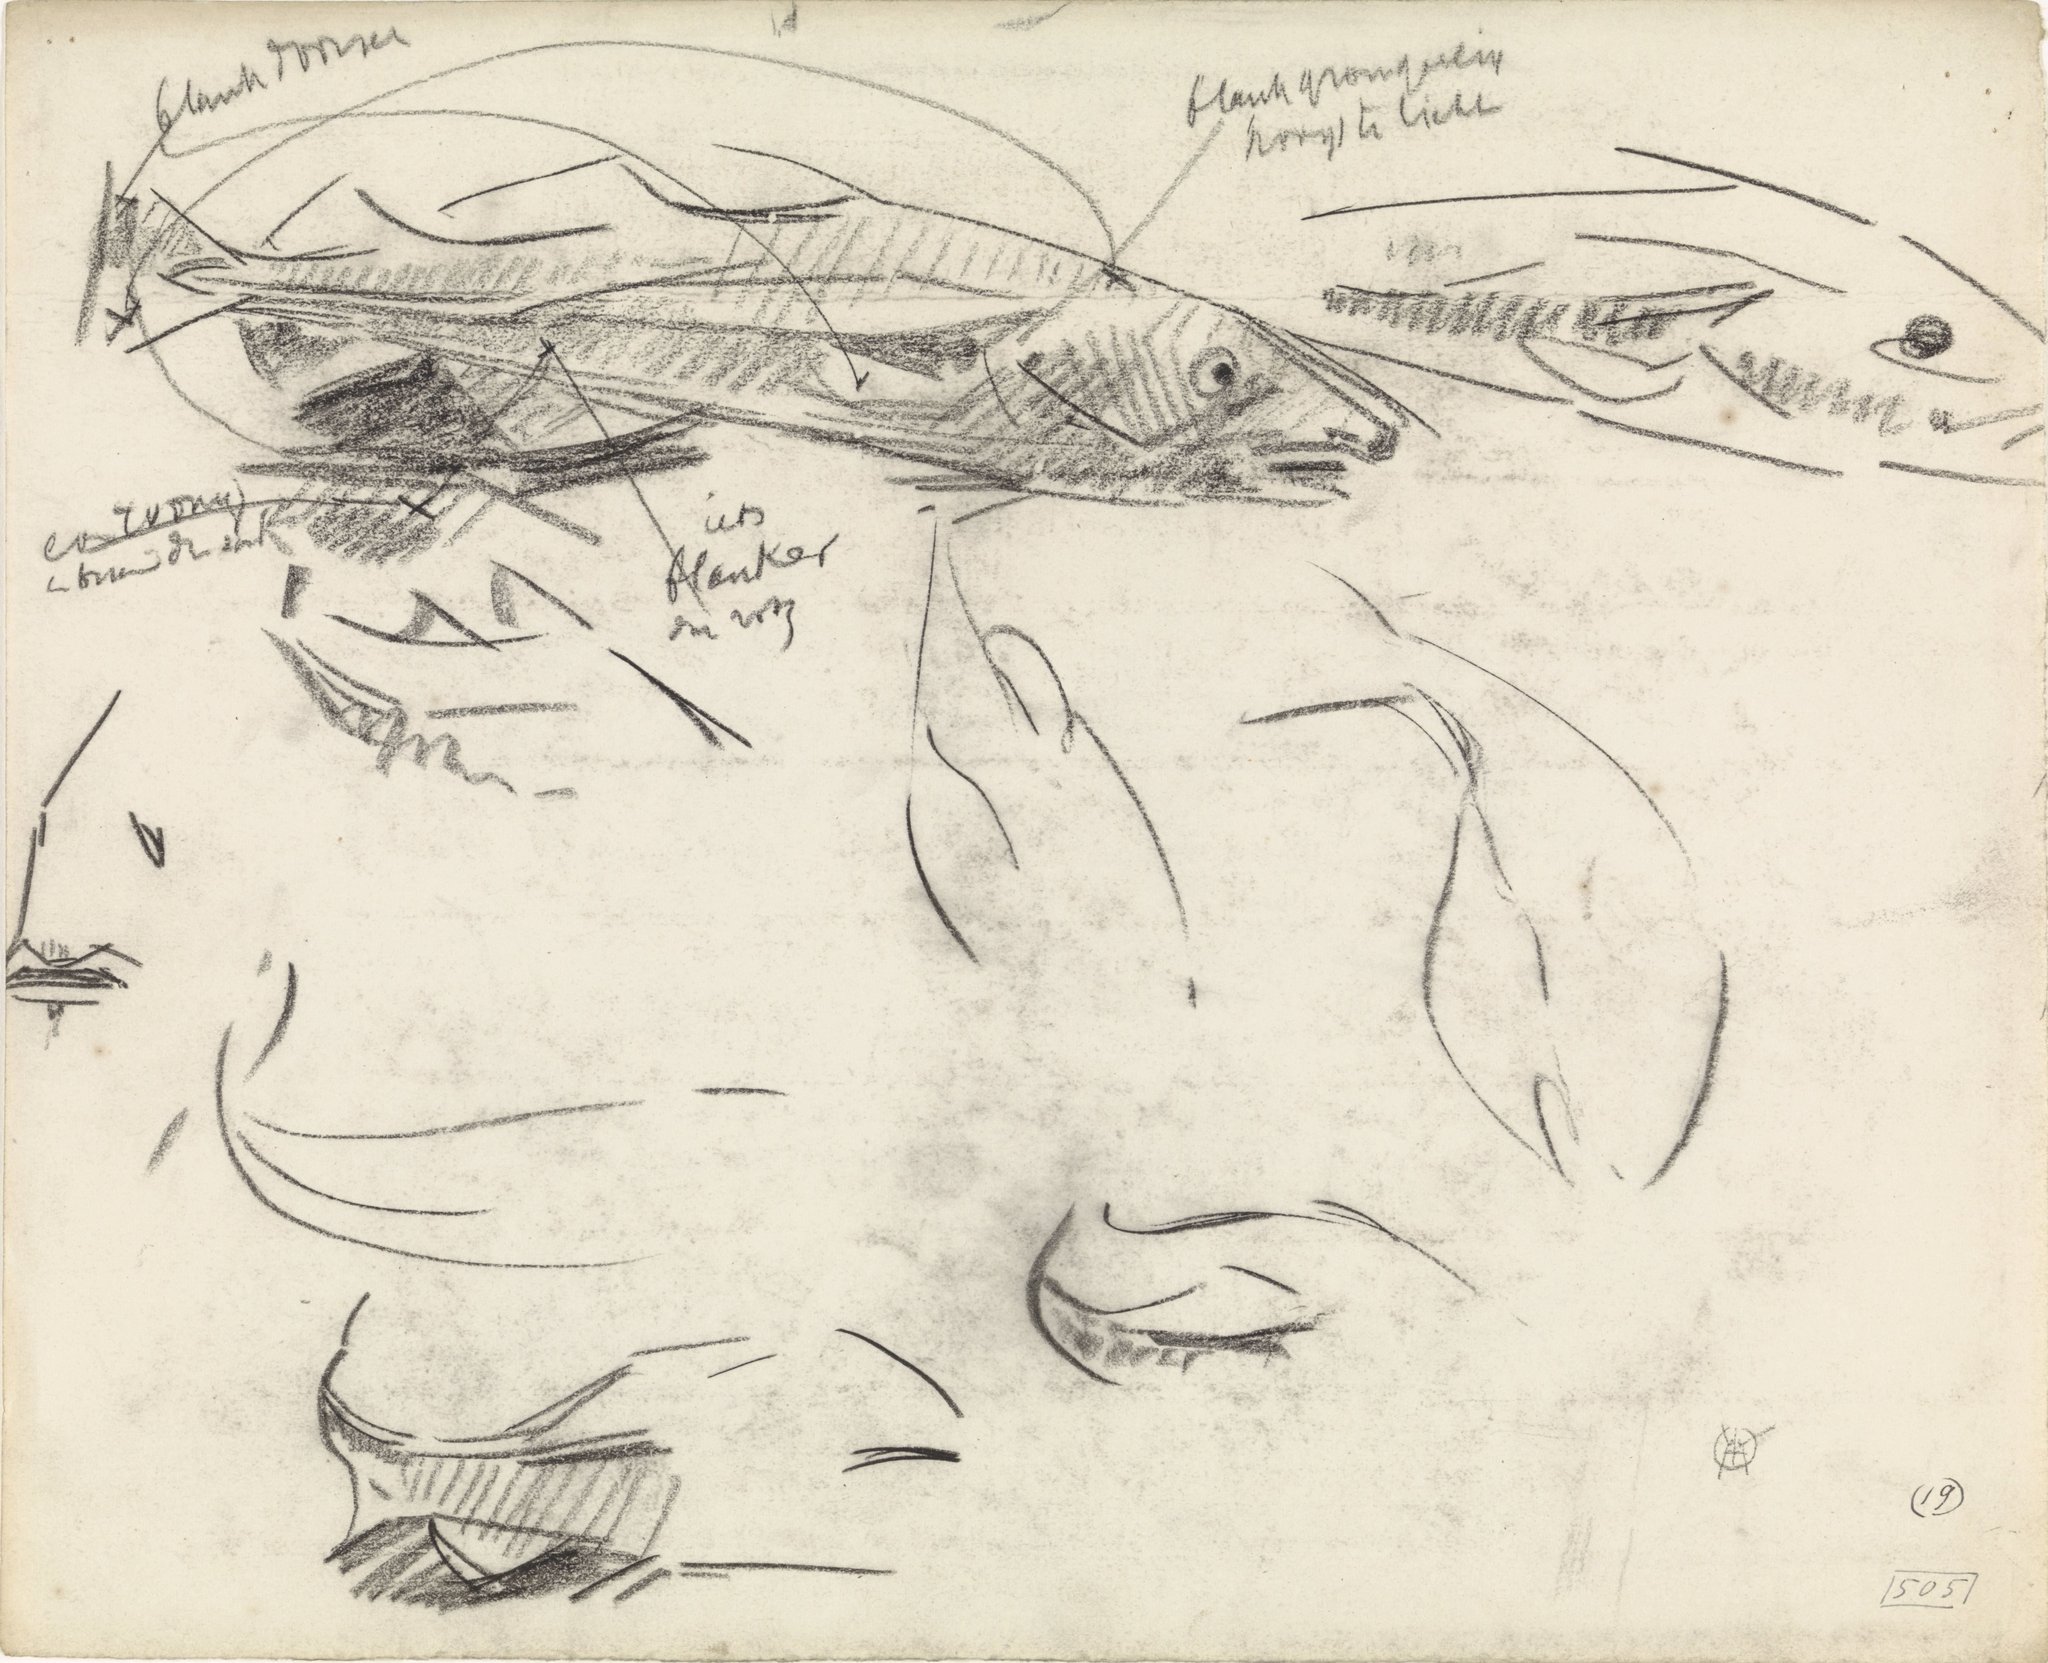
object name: drawing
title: Studies van een vis, met kleurnotities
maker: gerrit willem dijsselhof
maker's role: designer, draughtsman, print maker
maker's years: 1866-1924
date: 1876-1924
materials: chalk, paper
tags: bony fishes